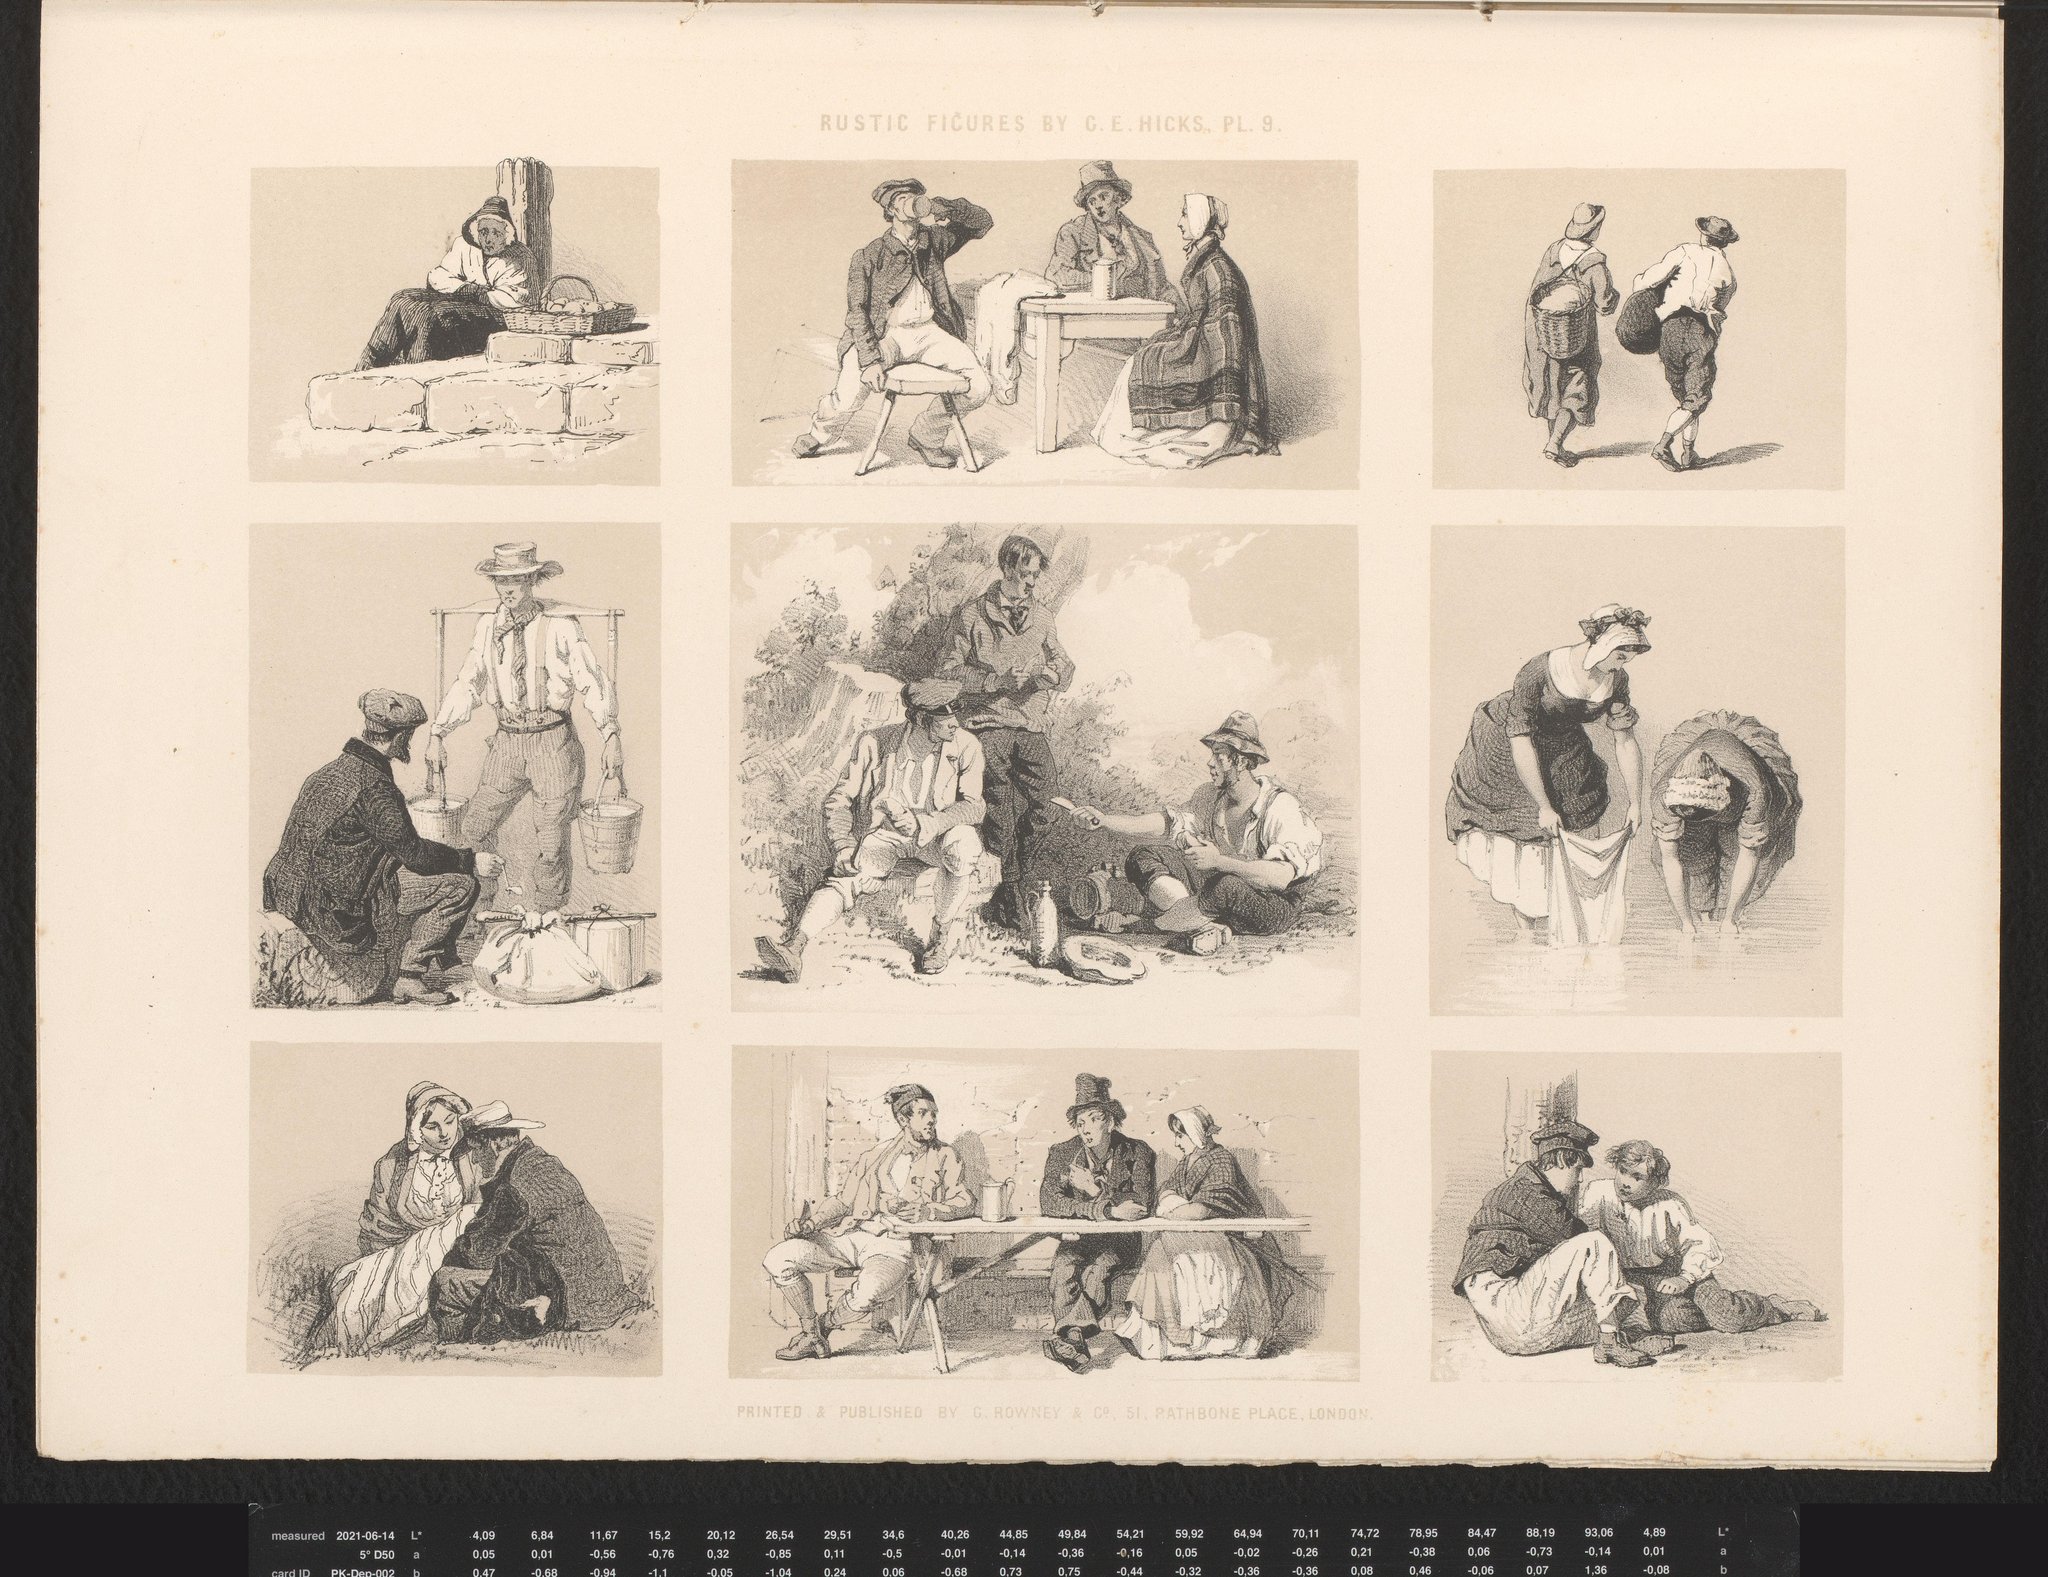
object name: print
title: Rustieke figuren door George Elgar Hicks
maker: george elgar hicks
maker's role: print maker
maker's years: 1824-1914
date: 1850-1855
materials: paper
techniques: tone lithography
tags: midday meal, lunch - cc - out of doors, carrying something, farmers, laundering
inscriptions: collector's mark: Lugt 2228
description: Deze prent behoort tot de serie 'Rustic figures by G.E. Hicks'. Deze serie is uitgegeven in tenminste drie delen met elk zes lithografieën.